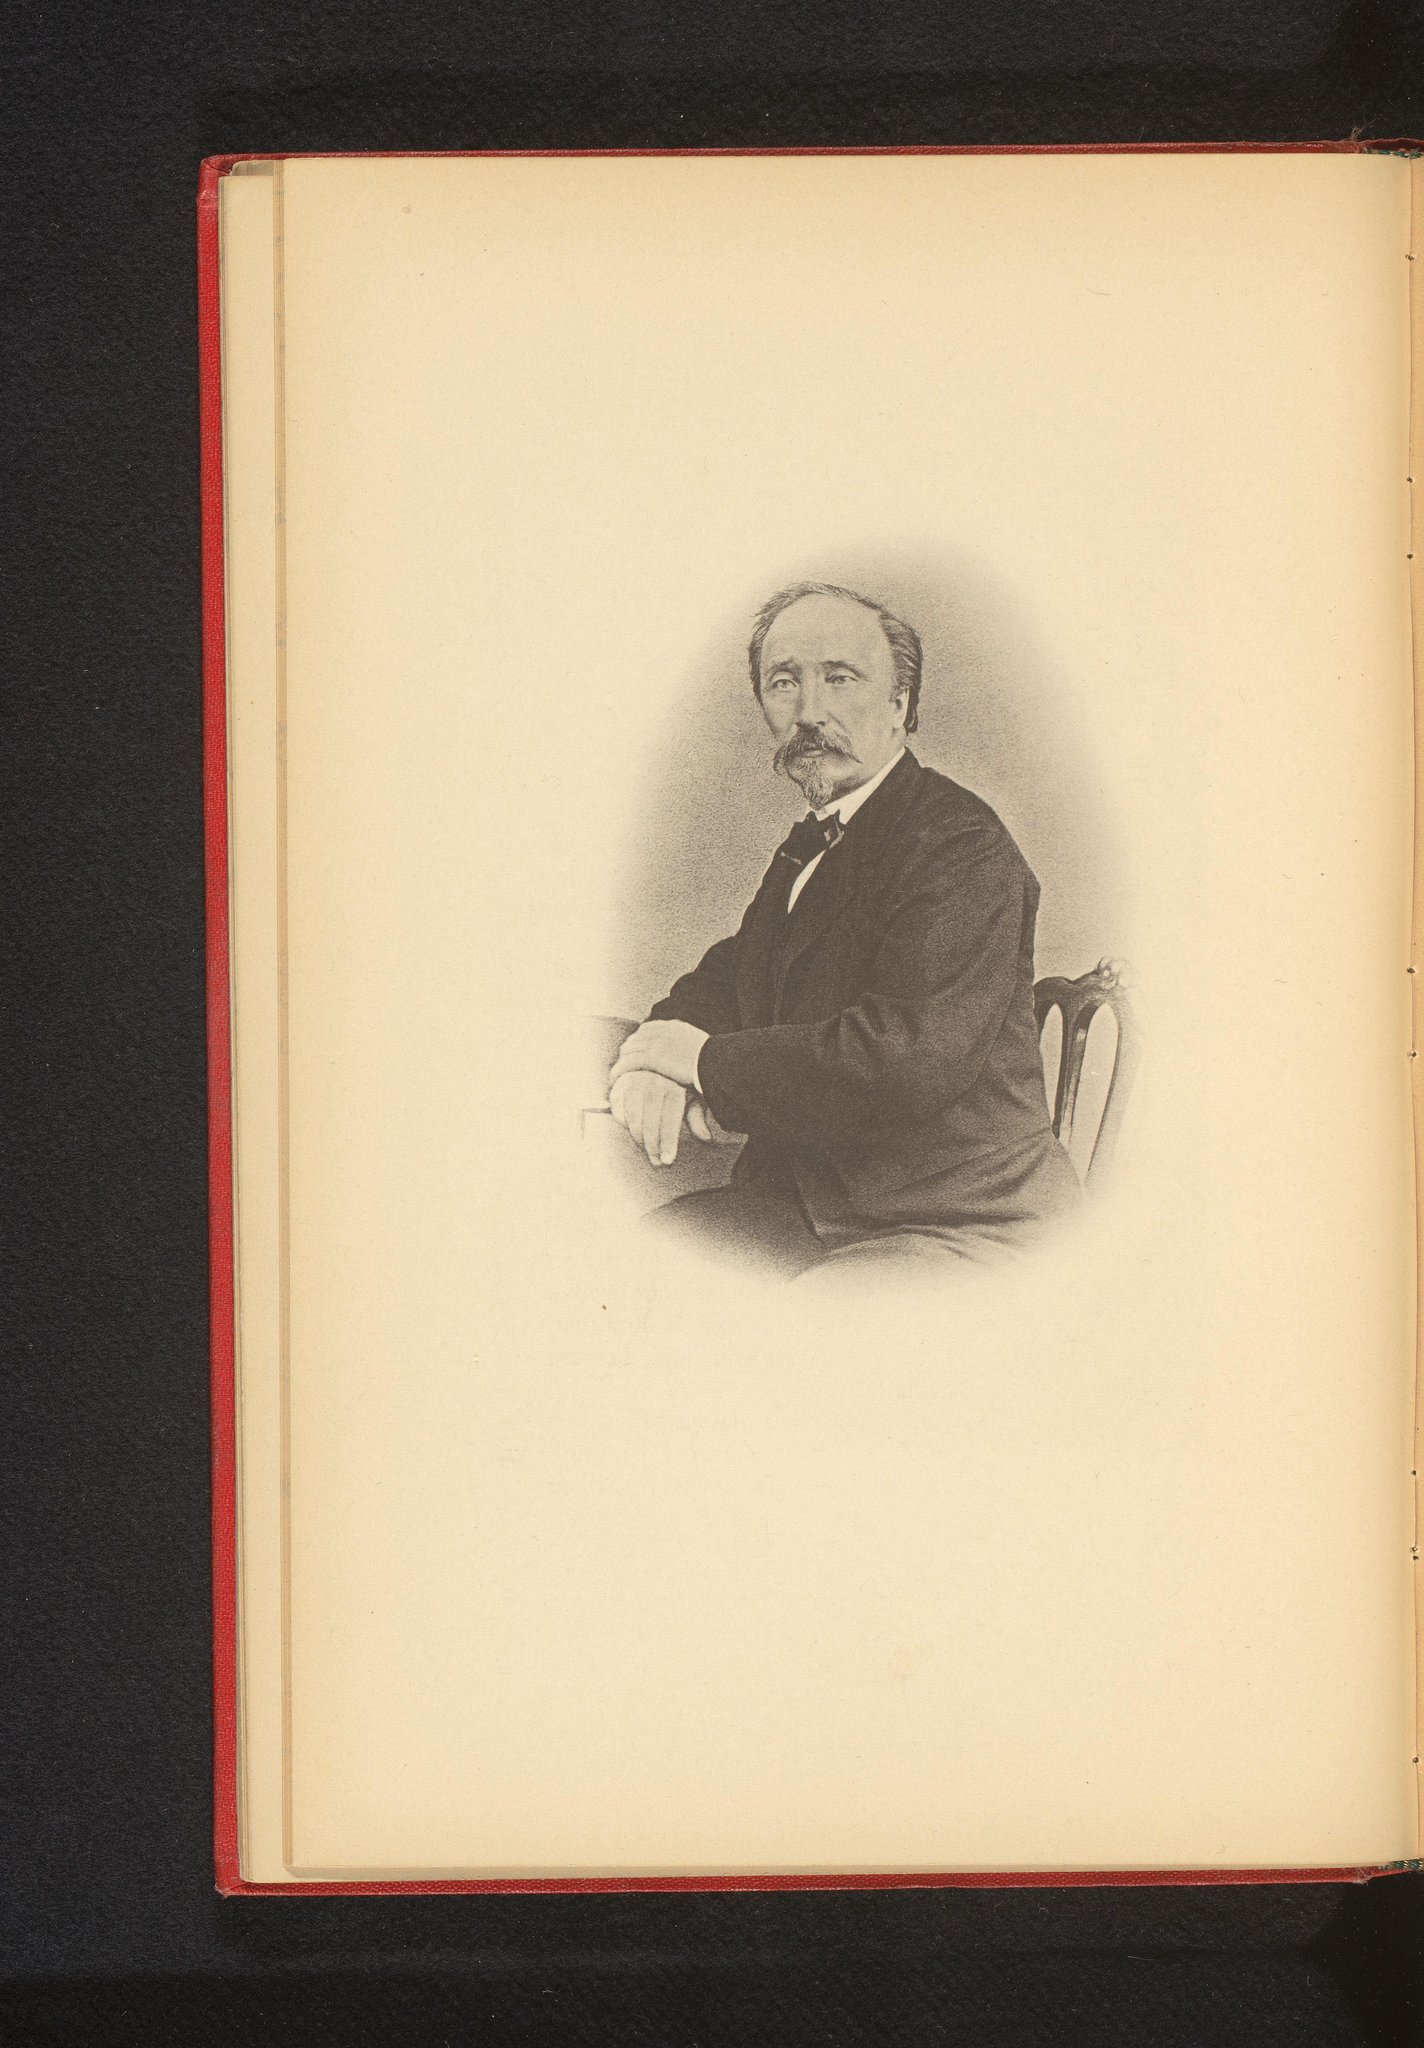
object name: photomechanical print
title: Portret van Erik Johan Löfgren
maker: Anonymous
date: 1873-1883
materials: paper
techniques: photograph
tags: portrait, self-portrait of painter